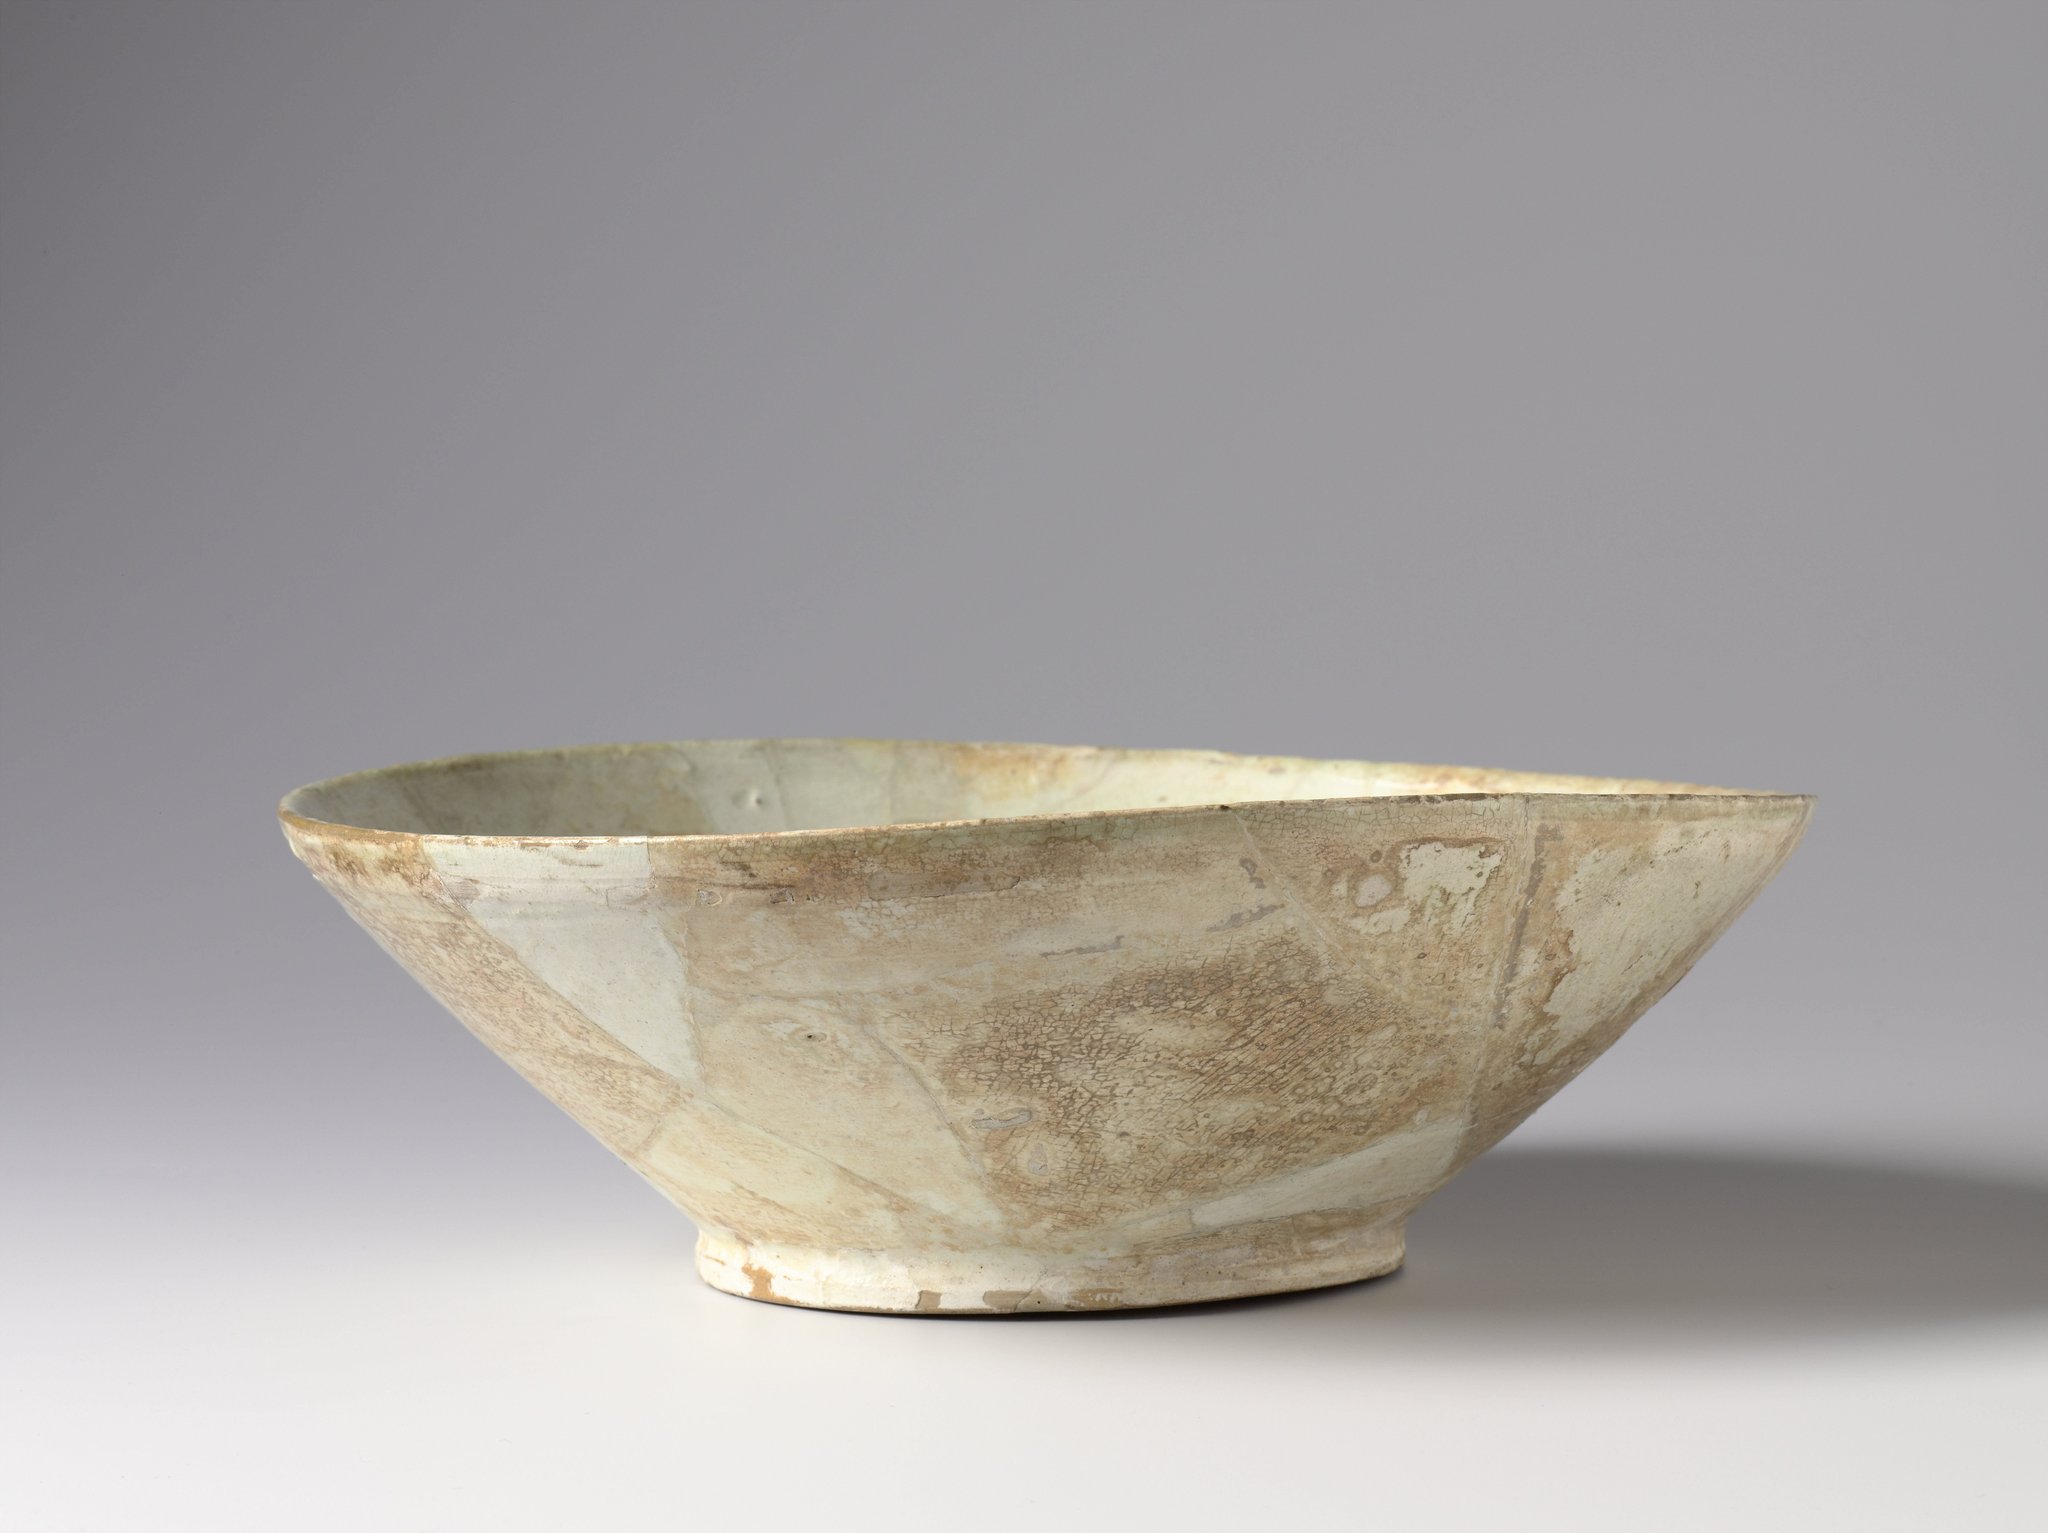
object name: bowl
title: Bowl with an inscription and a stylized bird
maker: Anonymous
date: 900-999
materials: earthenware, glaze, paint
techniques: firing, turning, vitrification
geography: nishapur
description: Aardewerken kom gedecoreerd met een schriftband en een gestileerde vogel in bruine slib op engobe van witte slib waarop een transparante glazuur is aangebracht.